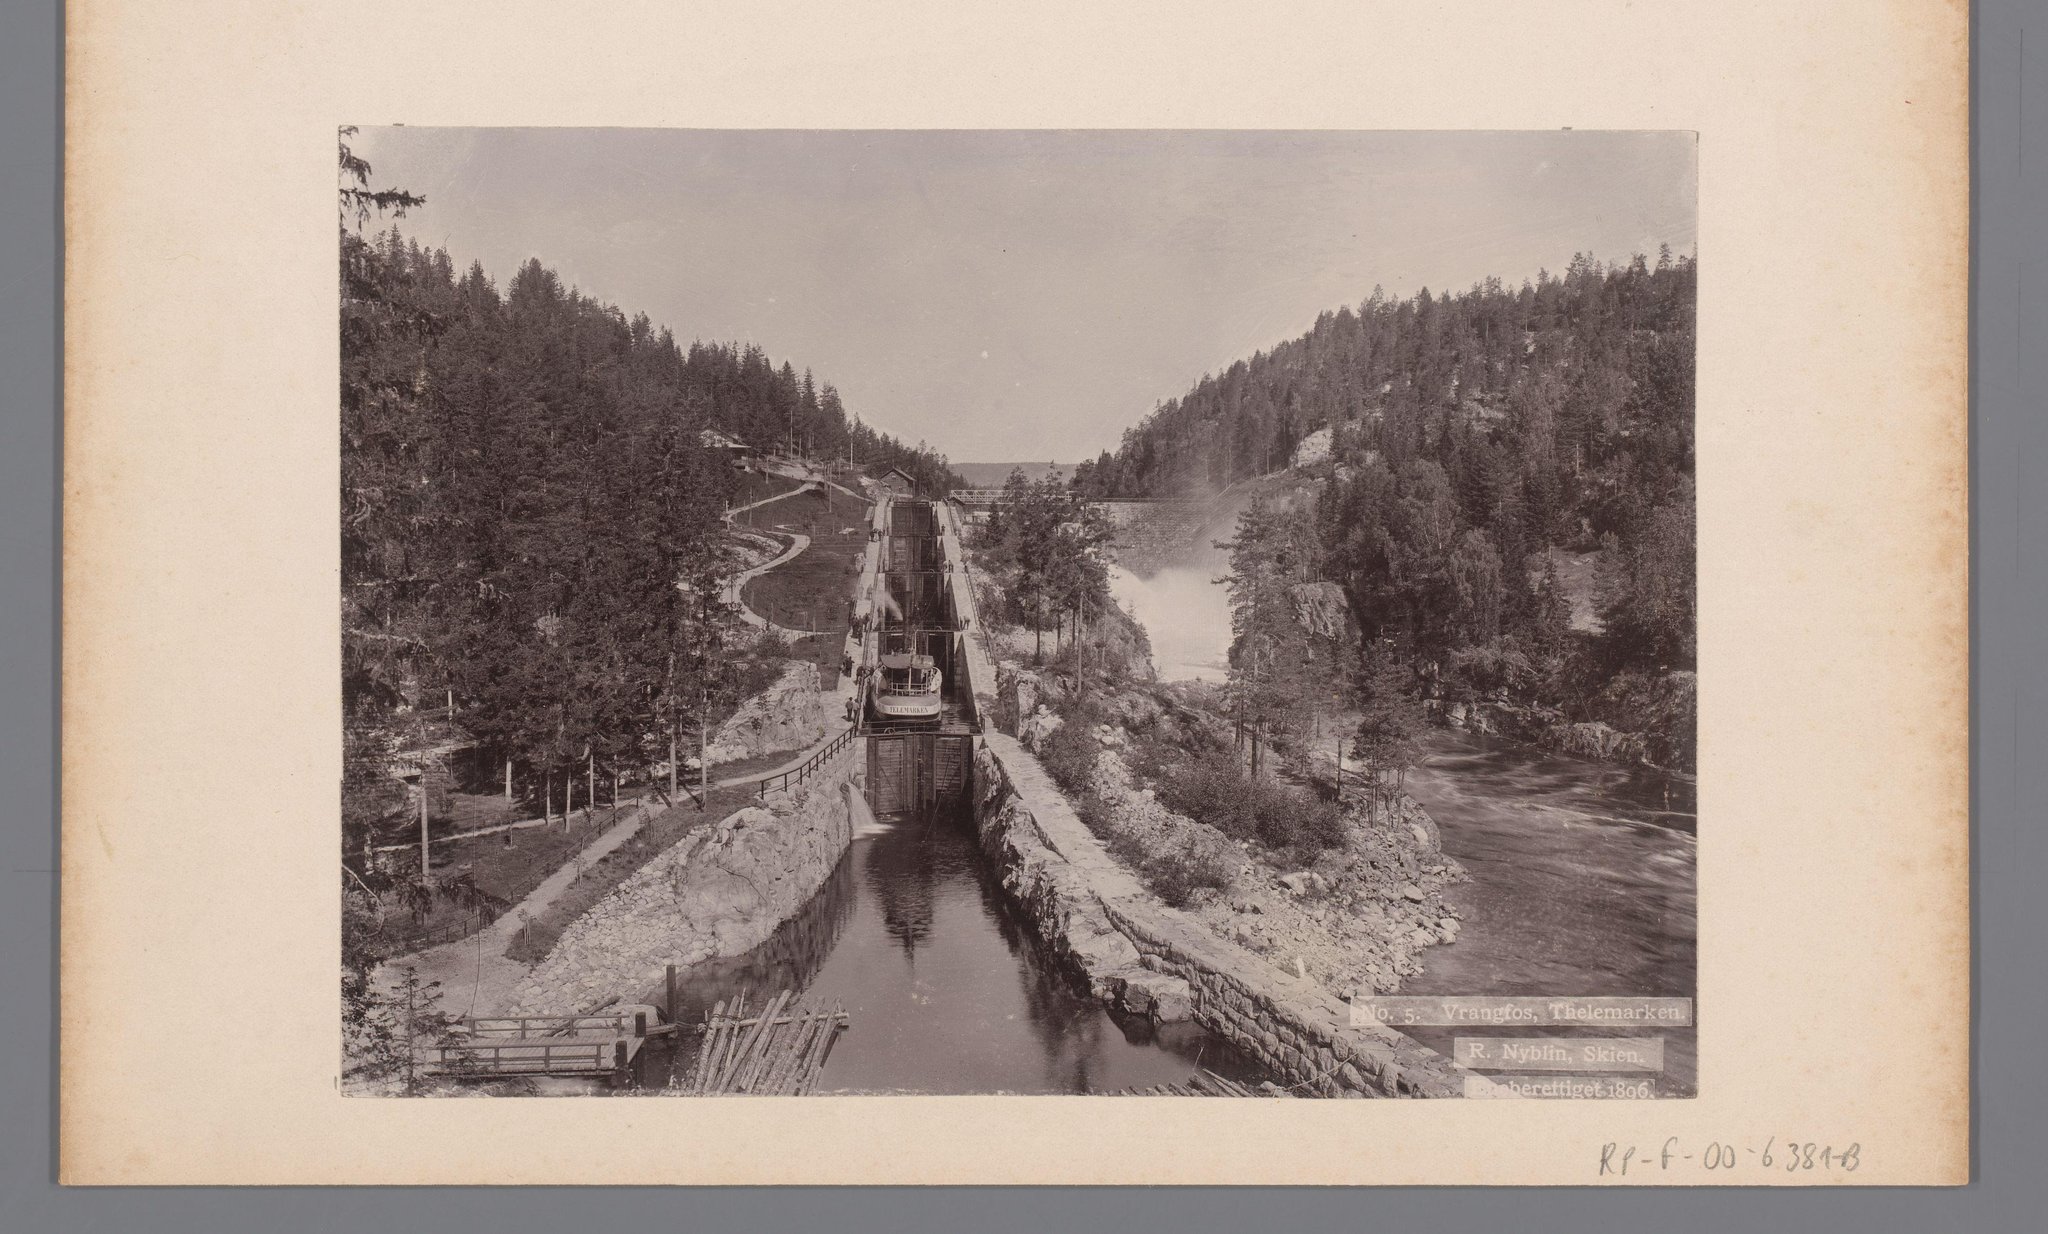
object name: photograph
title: "Bandakkanalen", Telemark [of Telemarken], Noorwegen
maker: ragnvald nyblin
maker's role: fotograaf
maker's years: 1867-1914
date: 1896-1915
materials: cardboard, photographic support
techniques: collodion silver print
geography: skien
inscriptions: caption: ‘R. Nyblin, Skien.’, caption: ‘34. Bandakkanalen Thelemakren (III)’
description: Boot die door sluis vaart, met de rivier ernaast. Het Telemarkkanaal (Telemarkskanalen) in Noorwegen bestaat uit twee kanalen, waarvan het Norsjø-Skien kanaal met sluizen in Skien en Løveid, gebouwd in 1854 tot 1861, het oudste is van de twee kanalen. Het andere kanaal zien we op de foto en is het Bandak-Norsjø kanaal geopend in 1892 =terminus post quem. Foto zit samen met RP-F-00-6381-B op één karton geplakt.